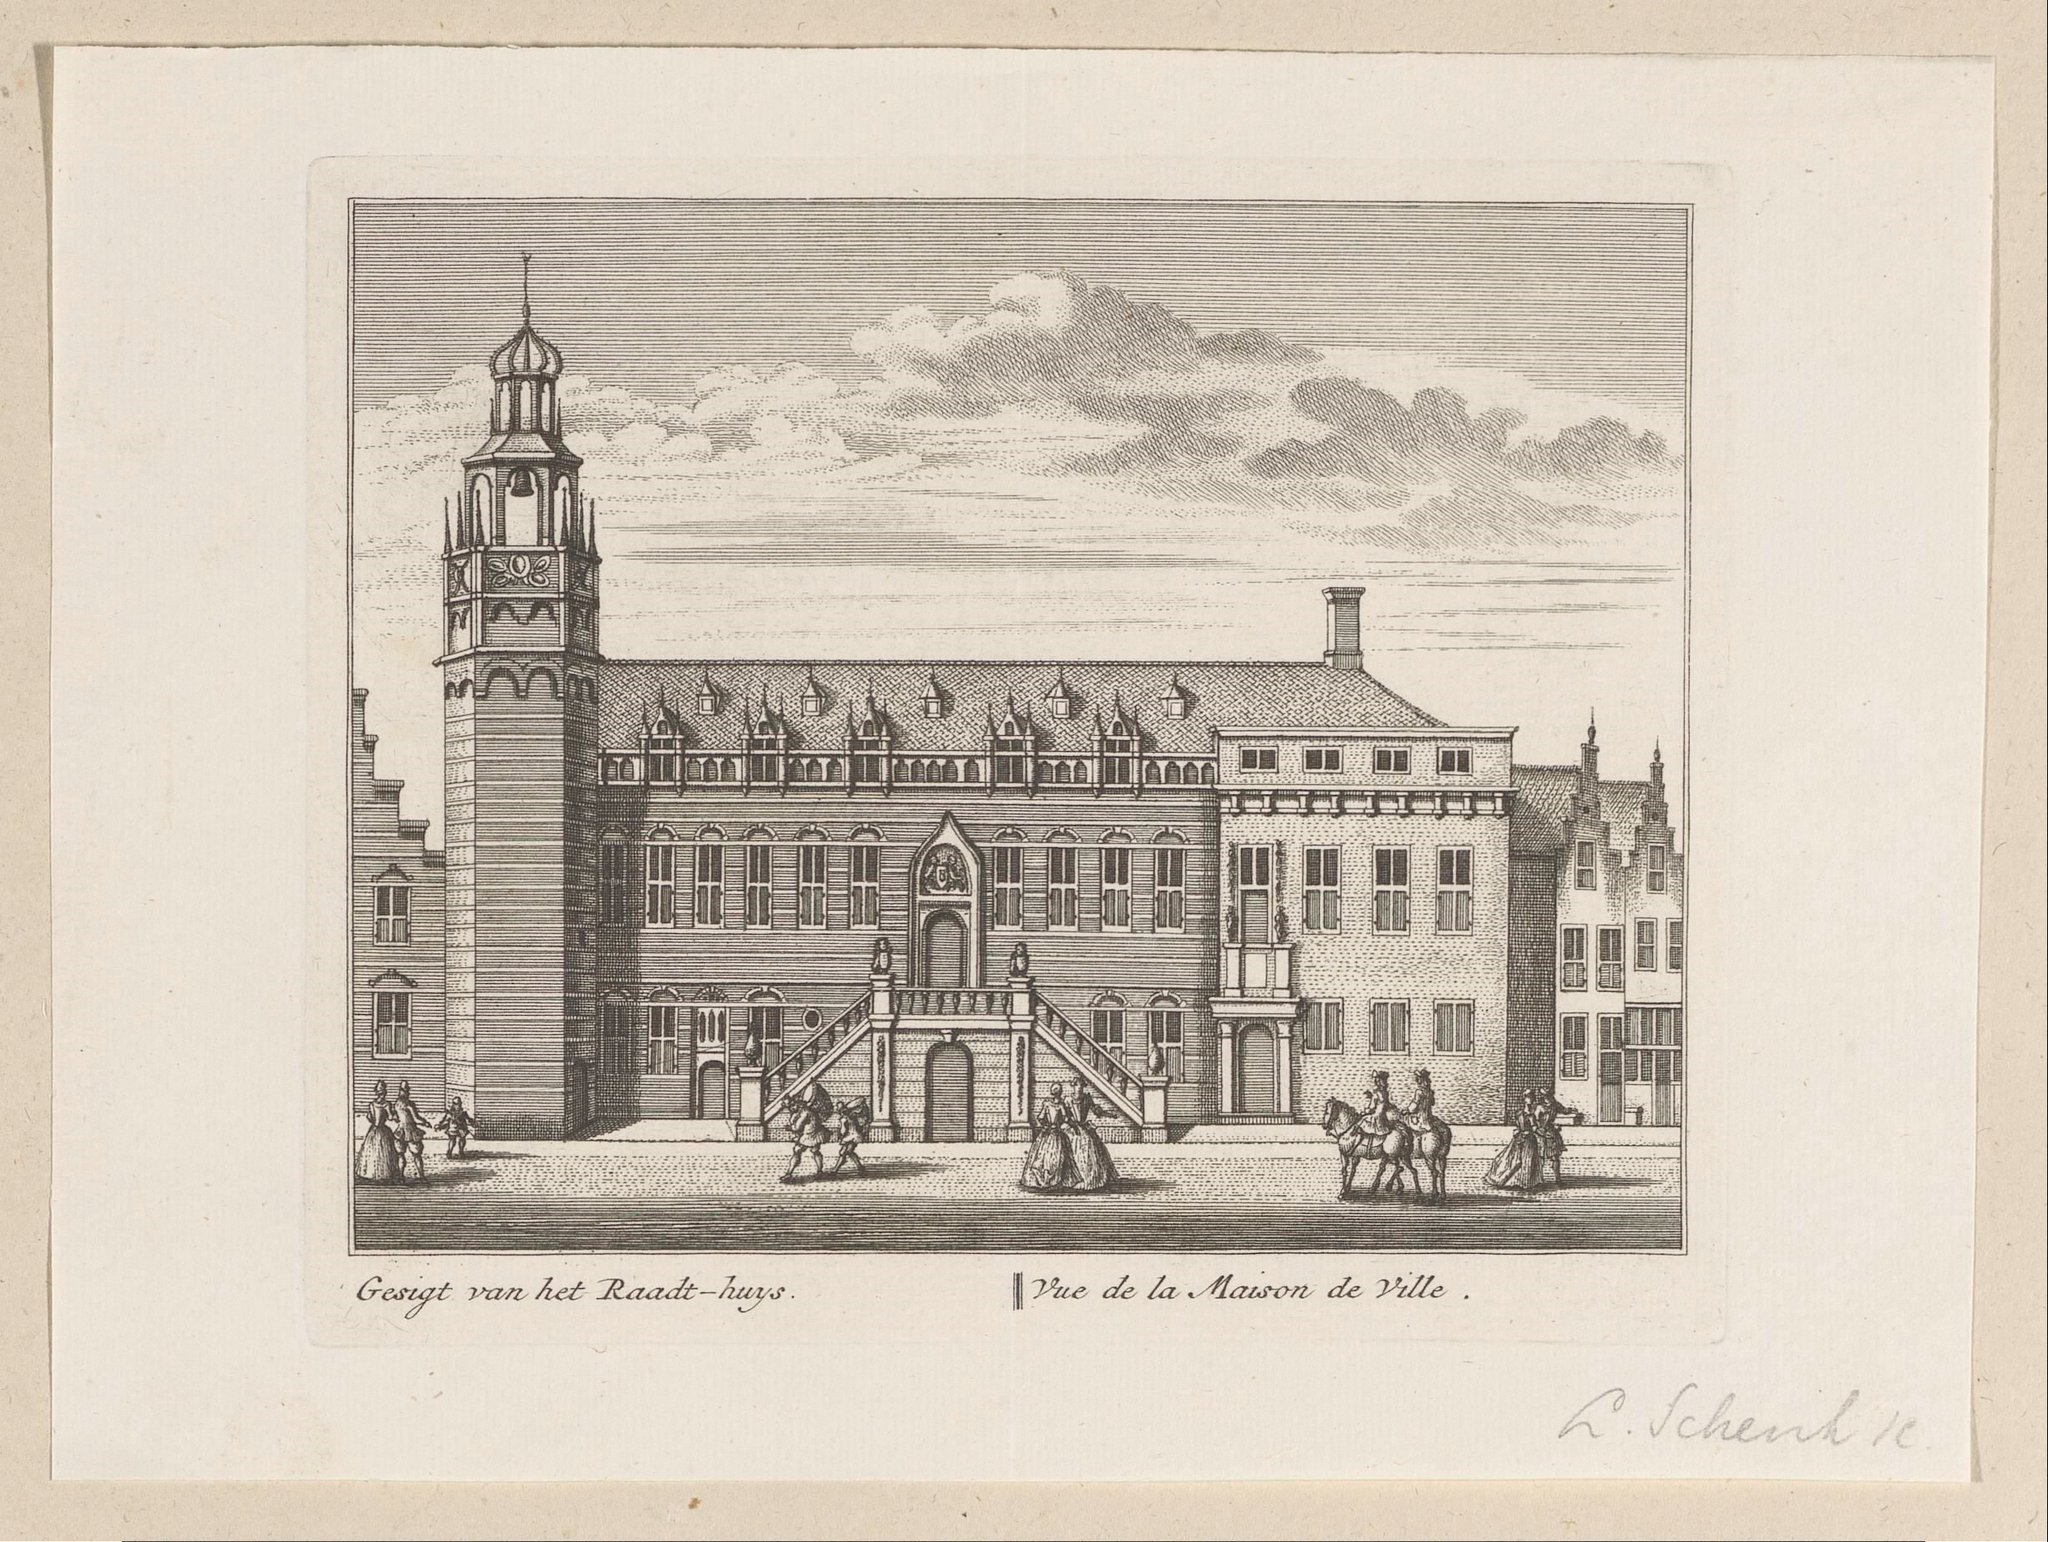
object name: print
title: Gesigt van het Raadt-huys / Vue de la Maison de Ville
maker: leonard schenk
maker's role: print maker, publisher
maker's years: 1696-1767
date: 1736-1746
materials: paper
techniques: etching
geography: amsterdam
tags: townhall, weigh-house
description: Als onderdeel van een prentserie van gezichten op Alkmaar in een publicatie met drie prentseries van stadsgezichten (op Alkmaar, Delft en Dordrecht) is deze prent ook gebruikt in: Rademaker, Abraham. Alle de voornaamste gesigten van de wydberoemde steeden Alkmaar, Delft en Dordregt (...) / Toutes les principales vuës de la fameuse villes d'Alcmar, Delft & Dordregt (…). Amsterdam: Leonard Schenk, 1736. Als illustratie is deze prent ook gebruikt in: Woude, C. van der. Kronyck van Alckmaar. Met zyn dorpen (…). 2e druk. Amsterdam: Steven van Esveldt, 1743. En in: Woude, C. van der. Kronyck van Alckmaar. Met zyn dorpen (…). 2e druk. Den Haag: Johannes de Cros, 1746. Uit welke druk het huidige exemplaar precies komt is niet na te gaan.